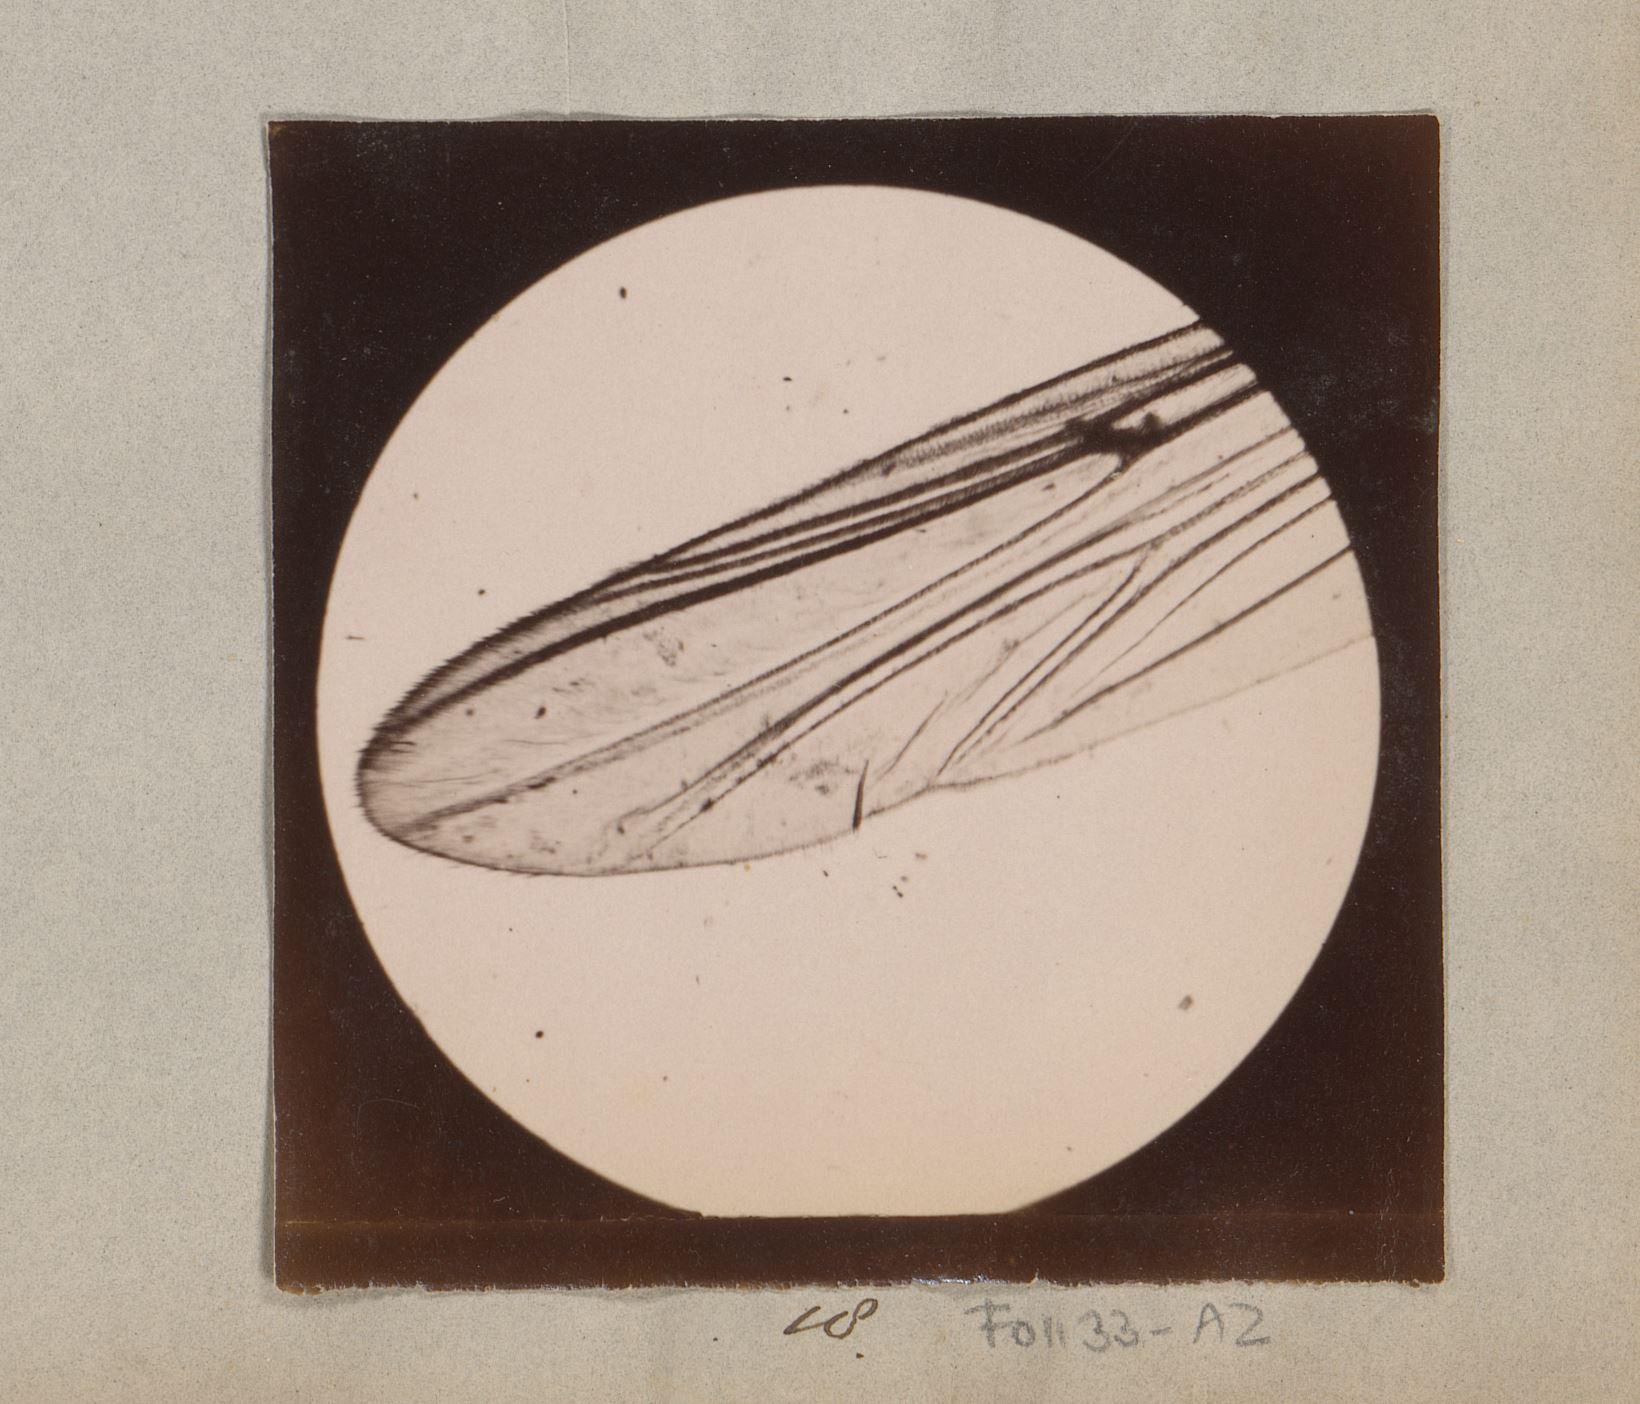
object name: photograph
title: Microscopische opname van de vleugel van een mug, 25 keer vergroot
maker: marinus pieter filbri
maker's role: instrument maker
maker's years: 1852-1917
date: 1887-1888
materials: paper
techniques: albumen print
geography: netherlands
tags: insects: mosquito, netherlands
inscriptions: number: ‘18’, inscription: ‘No. 18. Benaming vleugel eener Mug, 25 x vergroot, pose 4 m., bemerking id. eig. prep.’